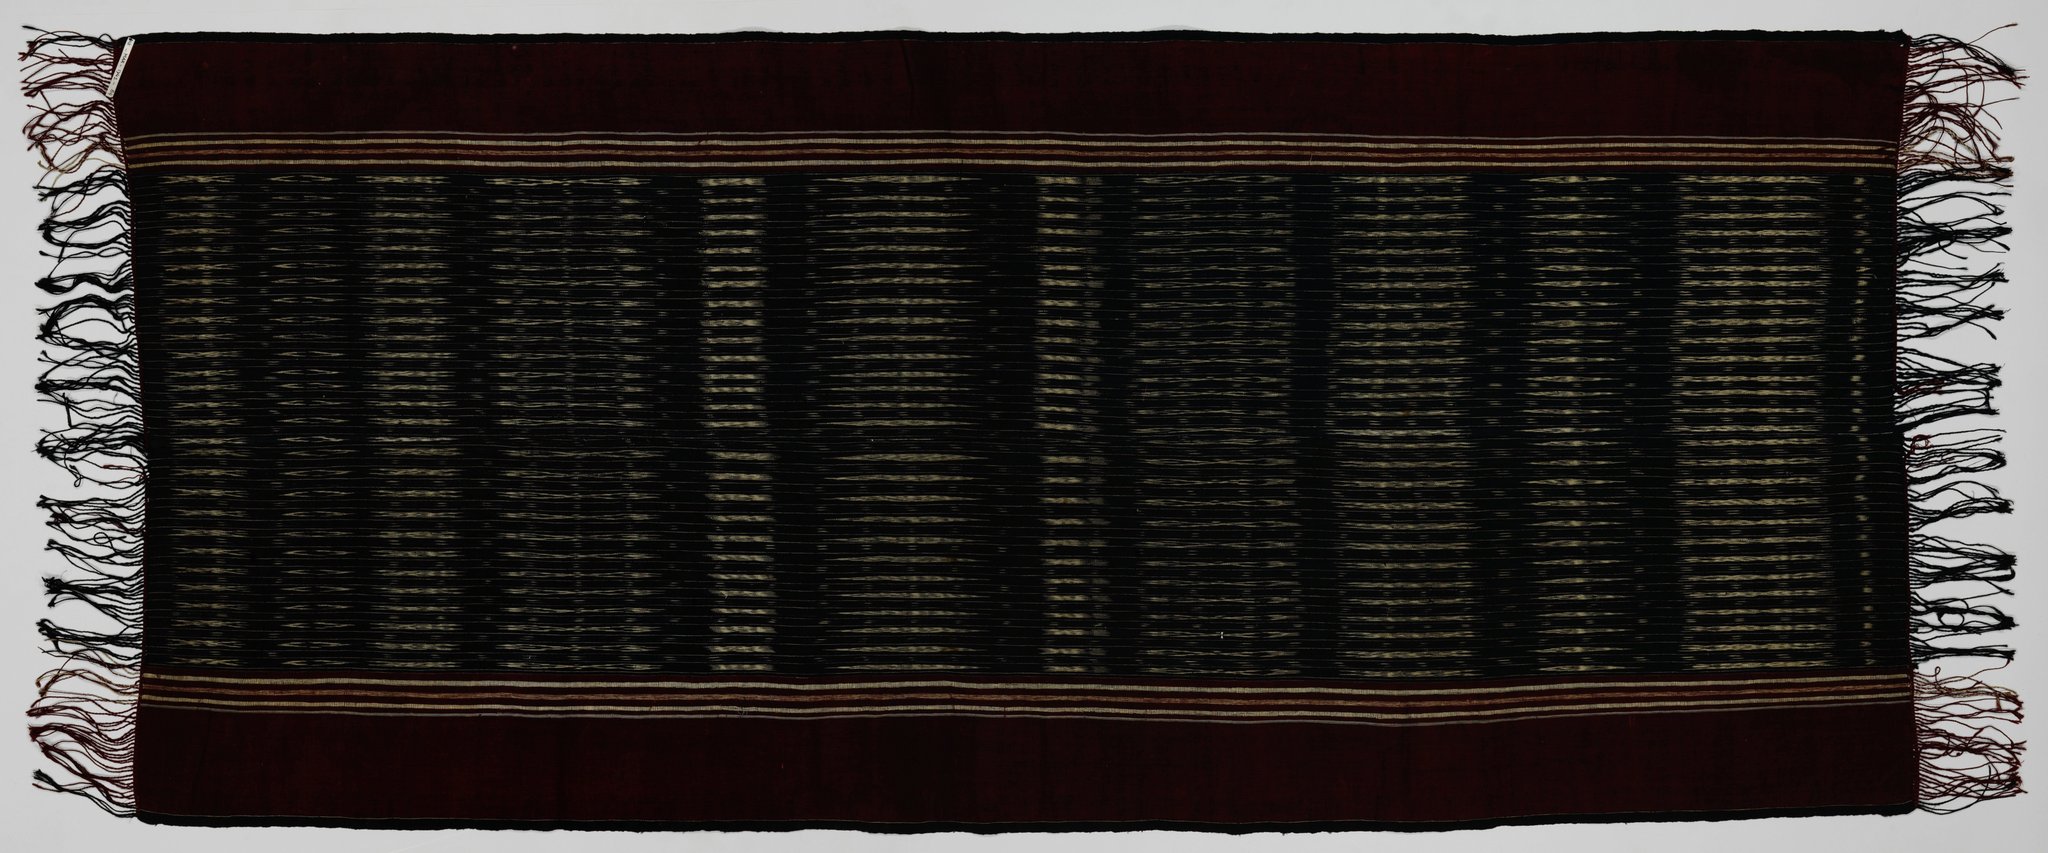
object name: schouderdoek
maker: Anonymous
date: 1900-1999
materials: cotton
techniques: weave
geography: north sumatra